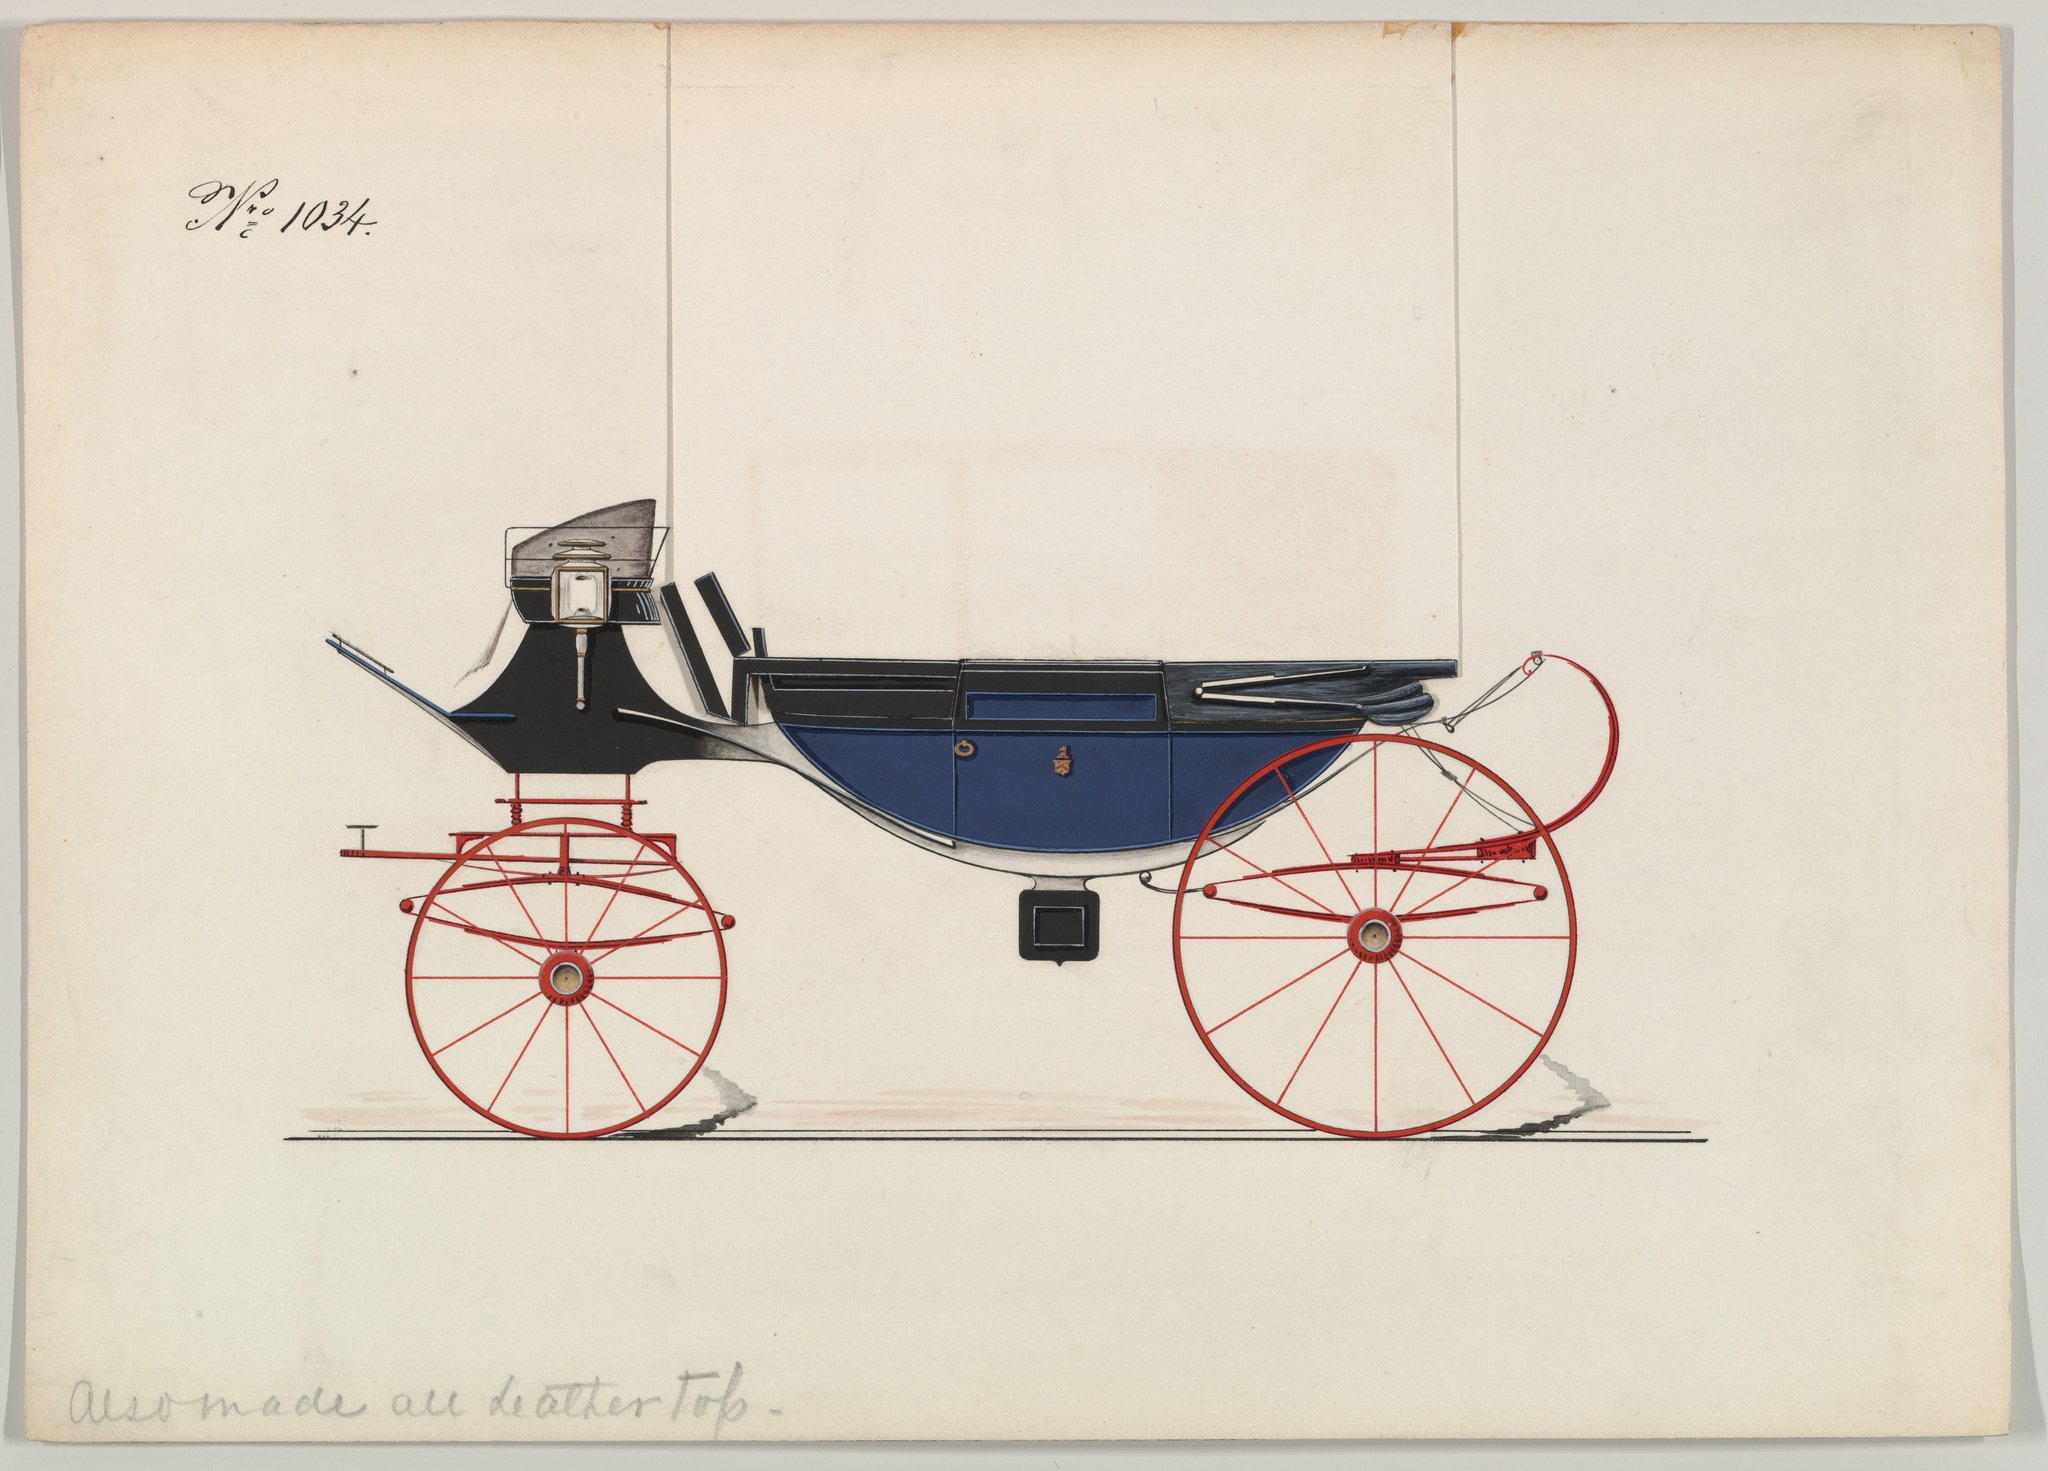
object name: drawing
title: Landau #1034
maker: brewster & co.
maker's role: manufacturer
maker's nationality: american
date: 1850-1870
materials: gouache, gum arabic, ink, watercolor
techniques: pen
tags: carriages